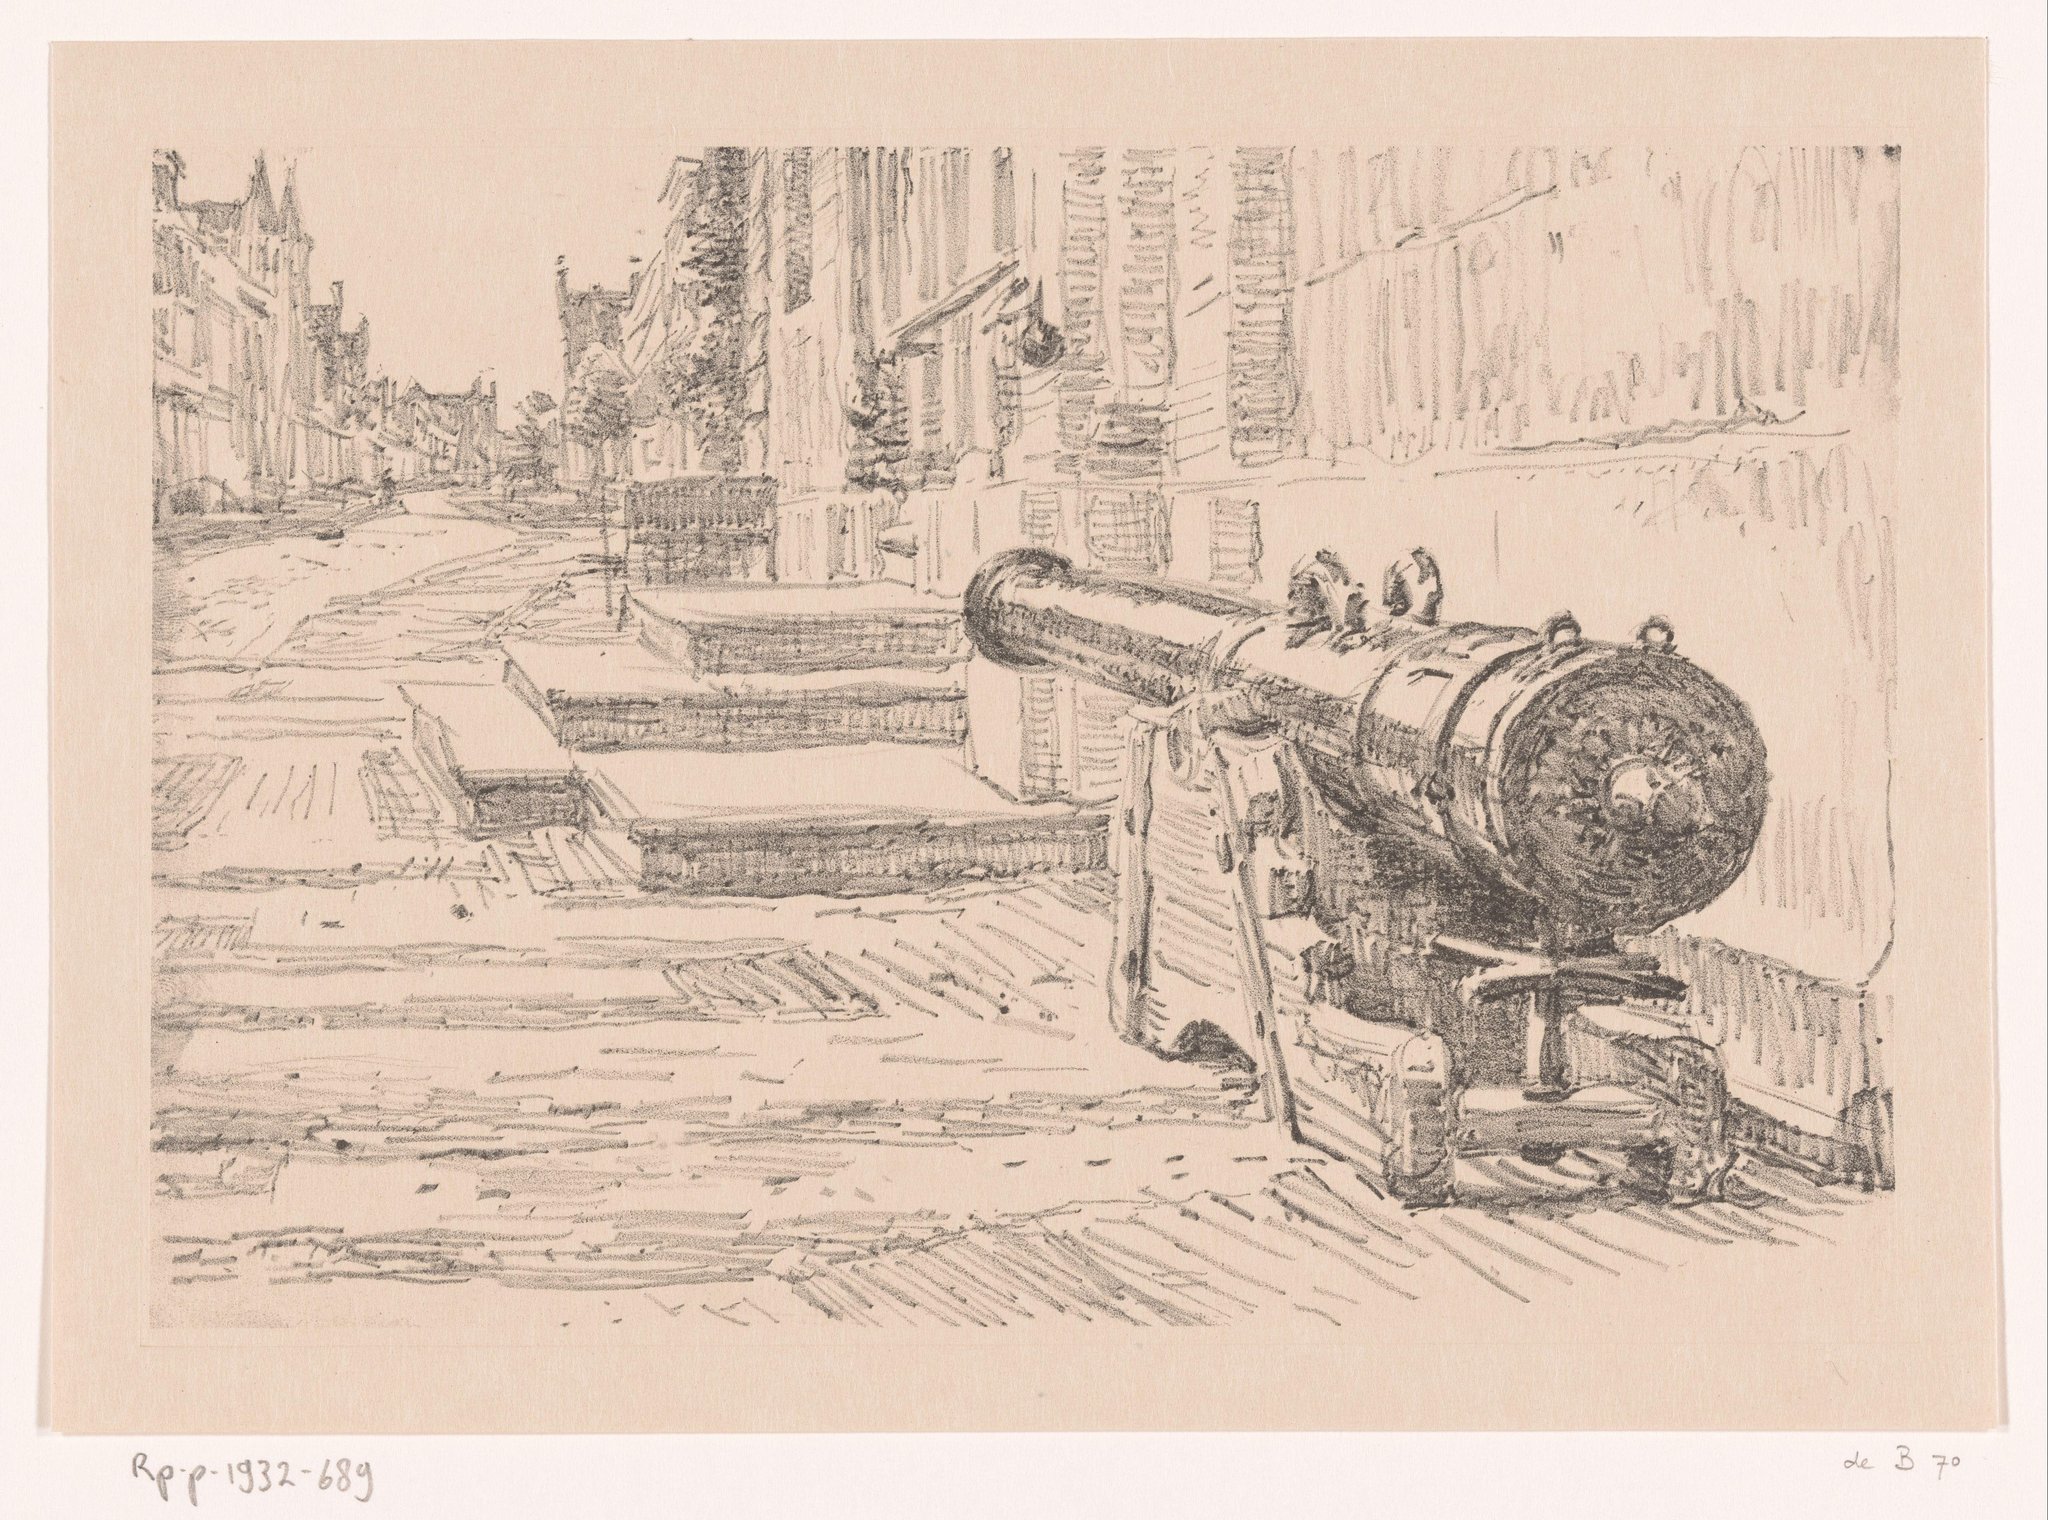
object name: print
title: Kanon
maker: willem bastiaan tholen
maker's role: draughtsman, painter, print maker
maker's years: 1860-1931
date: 1870-1931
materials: paper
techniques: lithograph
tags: firearms: cannon, street, enkhuizen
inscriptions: collector's mark: Lugt 2228